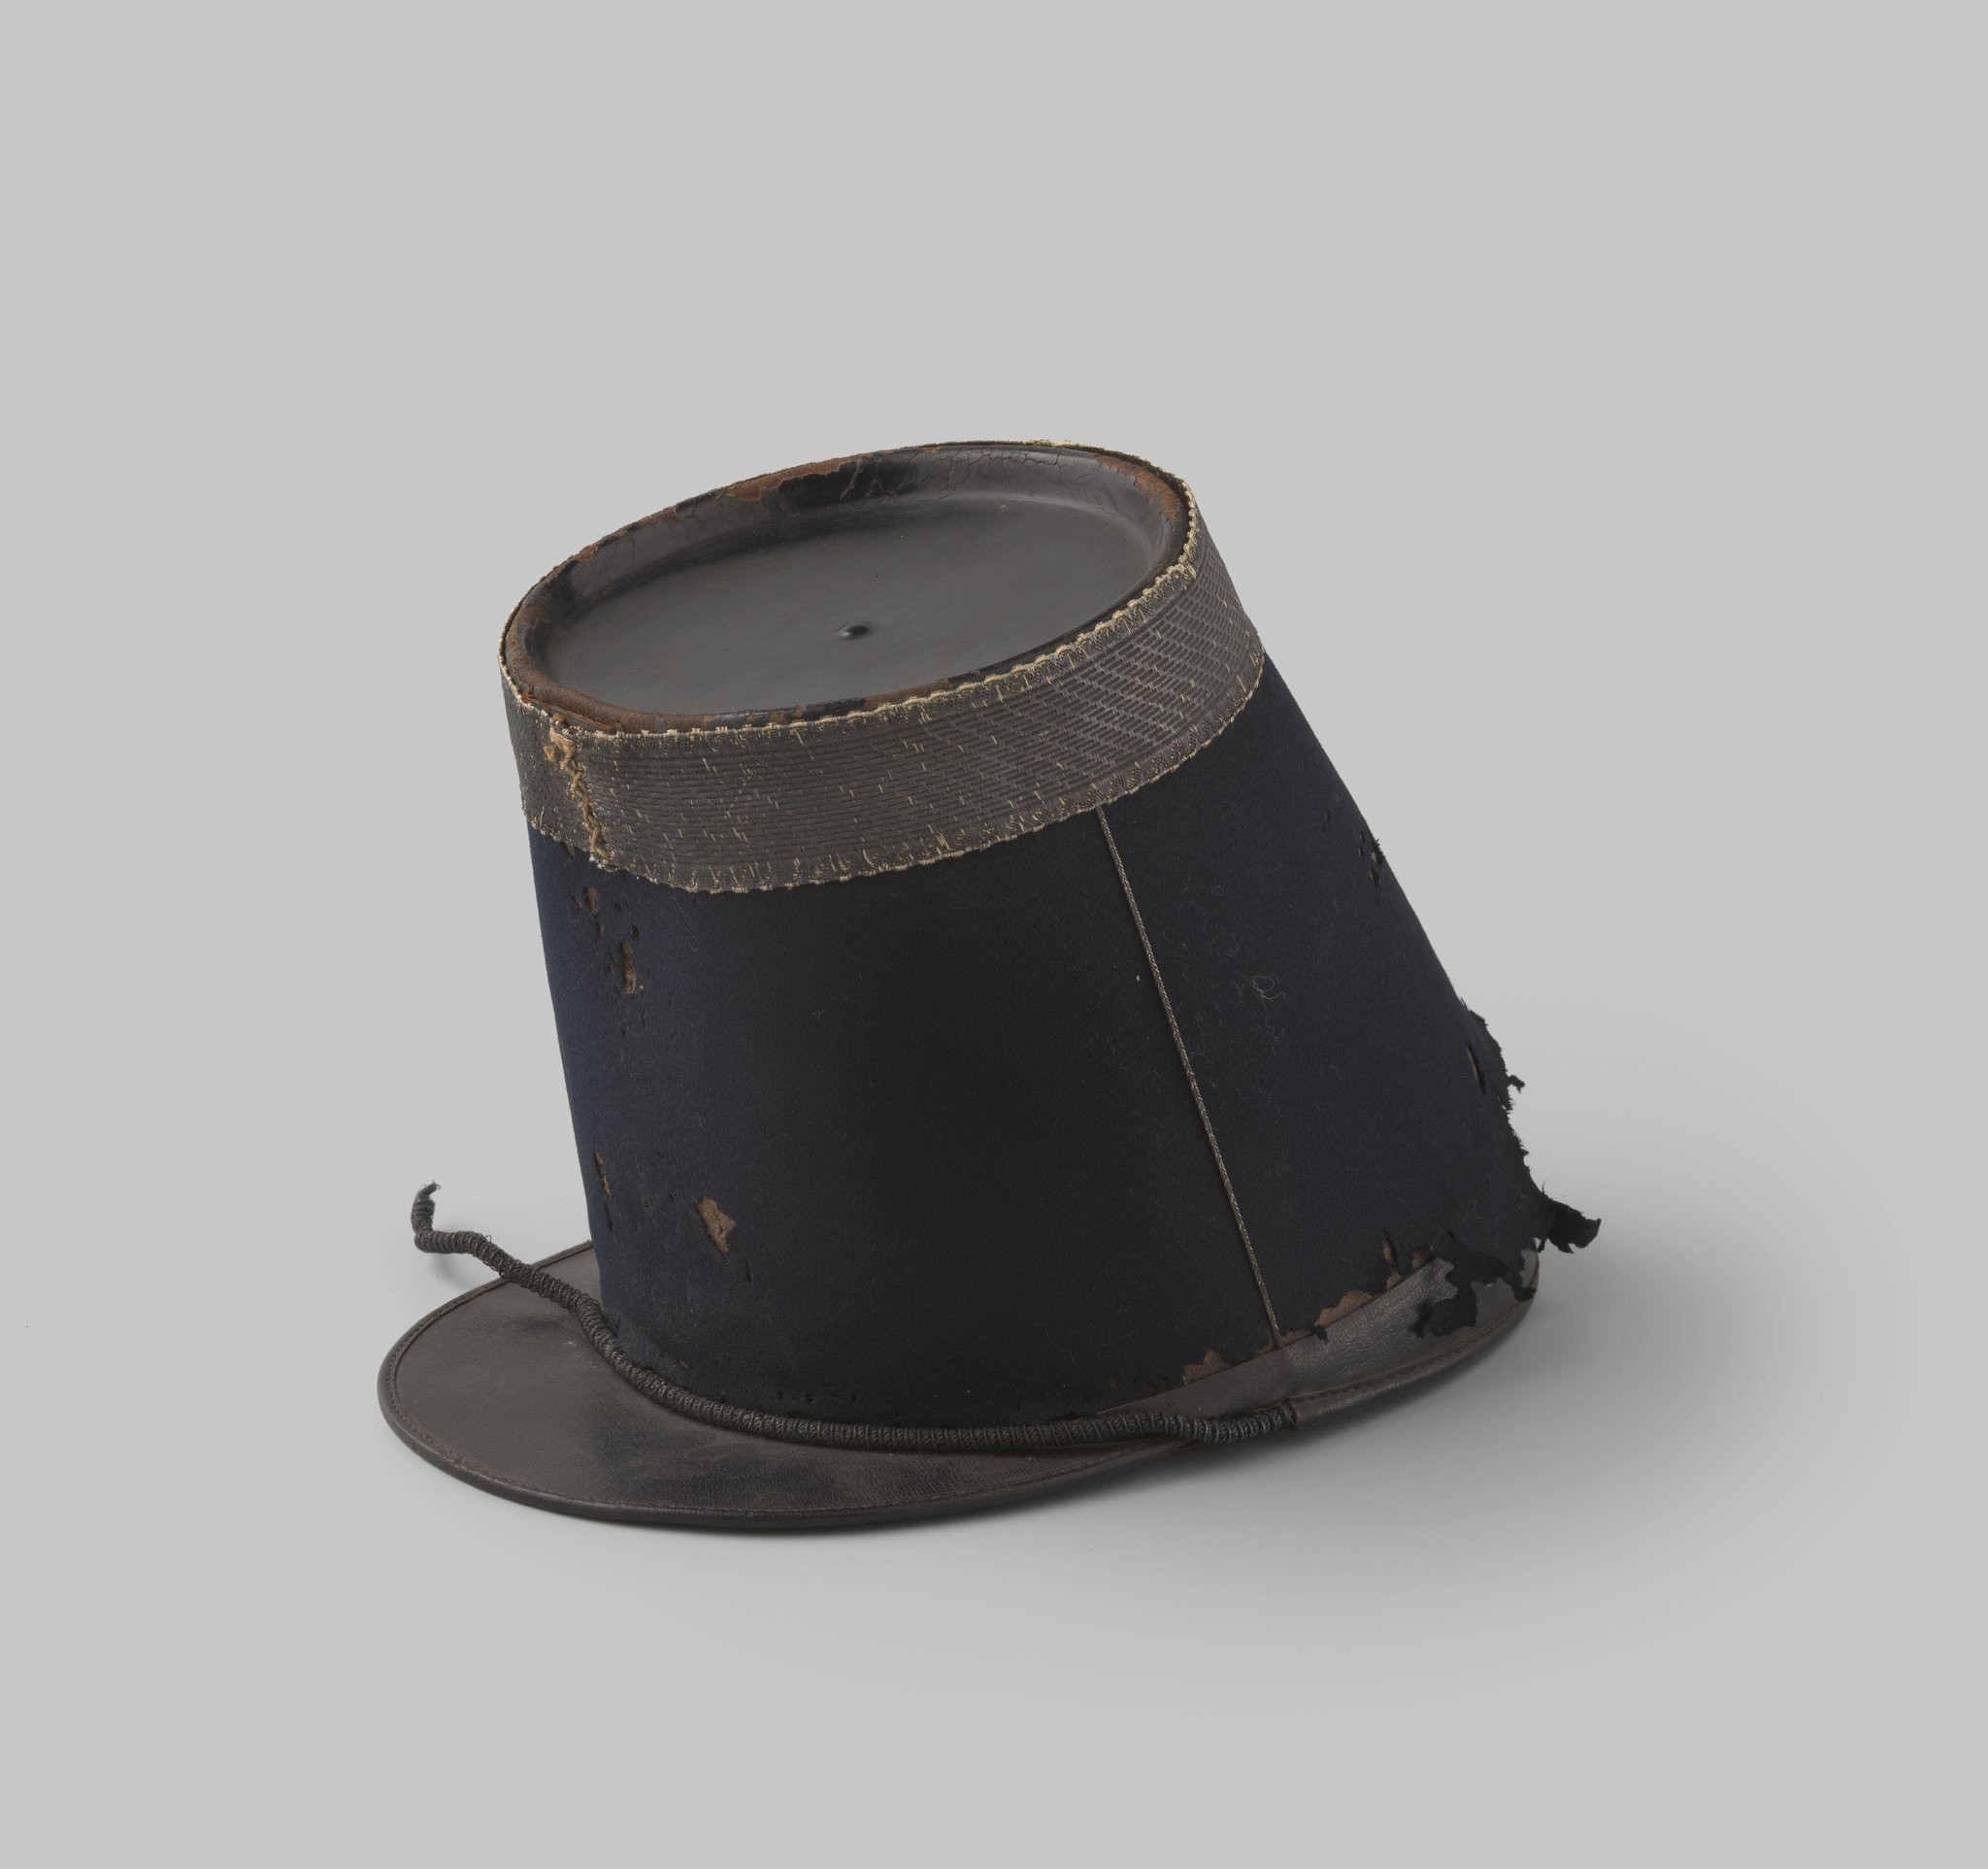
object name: kepie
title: Blauw laken kepie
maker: Anonymous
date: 1825-1832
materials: textile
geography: netherlands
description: Blauw laken kepie met leren klep en bodem, zilver wapen, galon, pompon en biezen. Ernstig door mot aangetast, cocarde [kokarde] en pompon ontbreken.